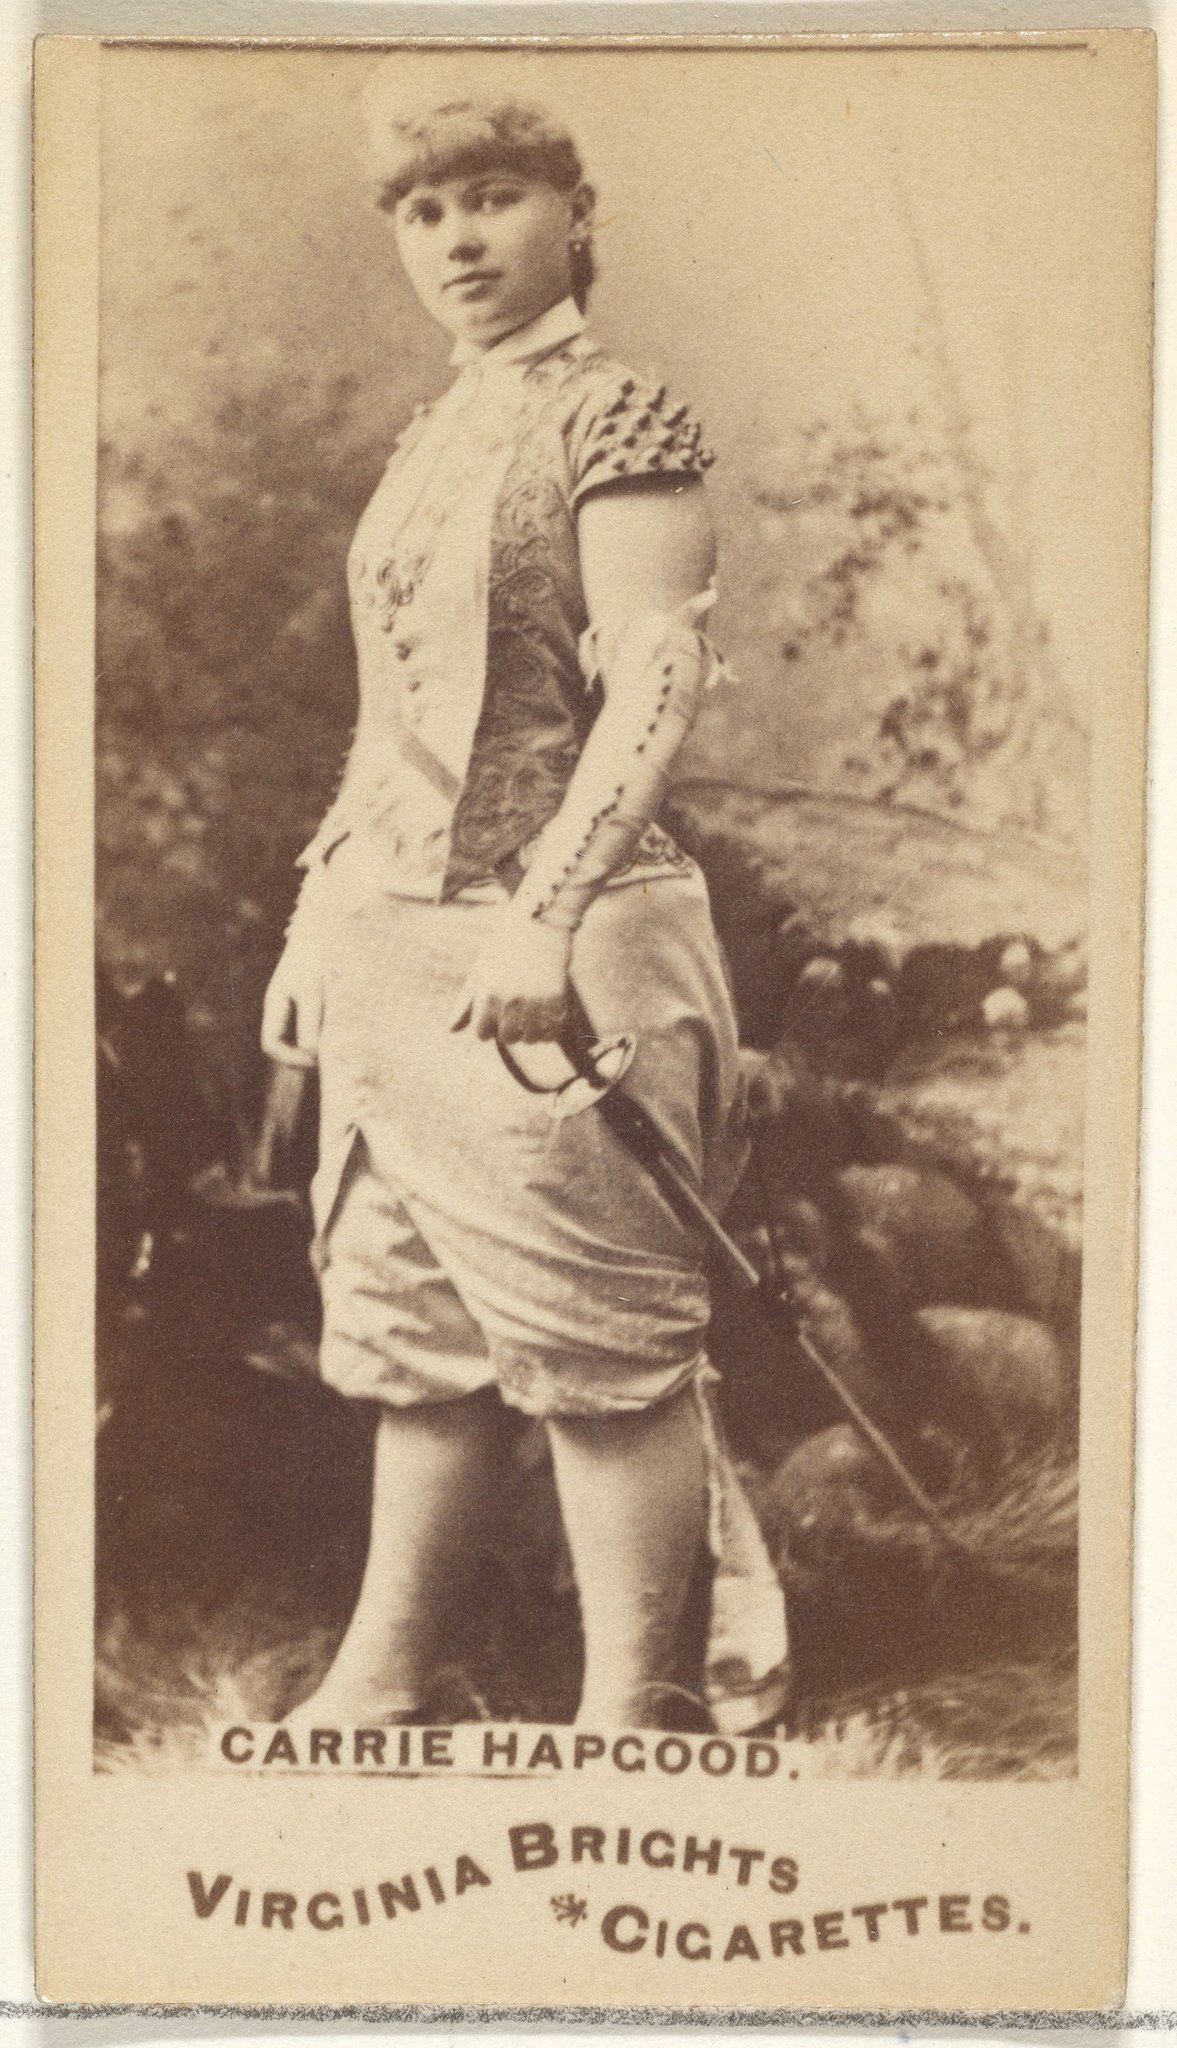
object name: photograph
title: Carrie Hapgood, from the Actors and Actresses series (N45, Type 1) for Virginia Brights Cigarettes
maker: allen & ginter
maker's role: publisher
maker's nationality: american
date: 1888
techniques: albumen silver print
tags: swords,portraits,women,actresses